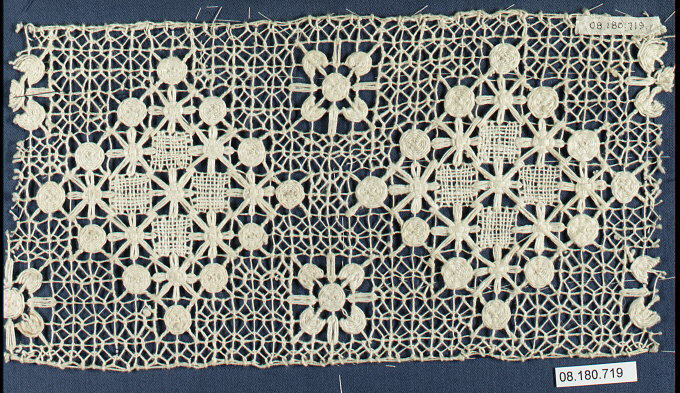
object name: fragment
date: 1801-1900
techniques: embroidery